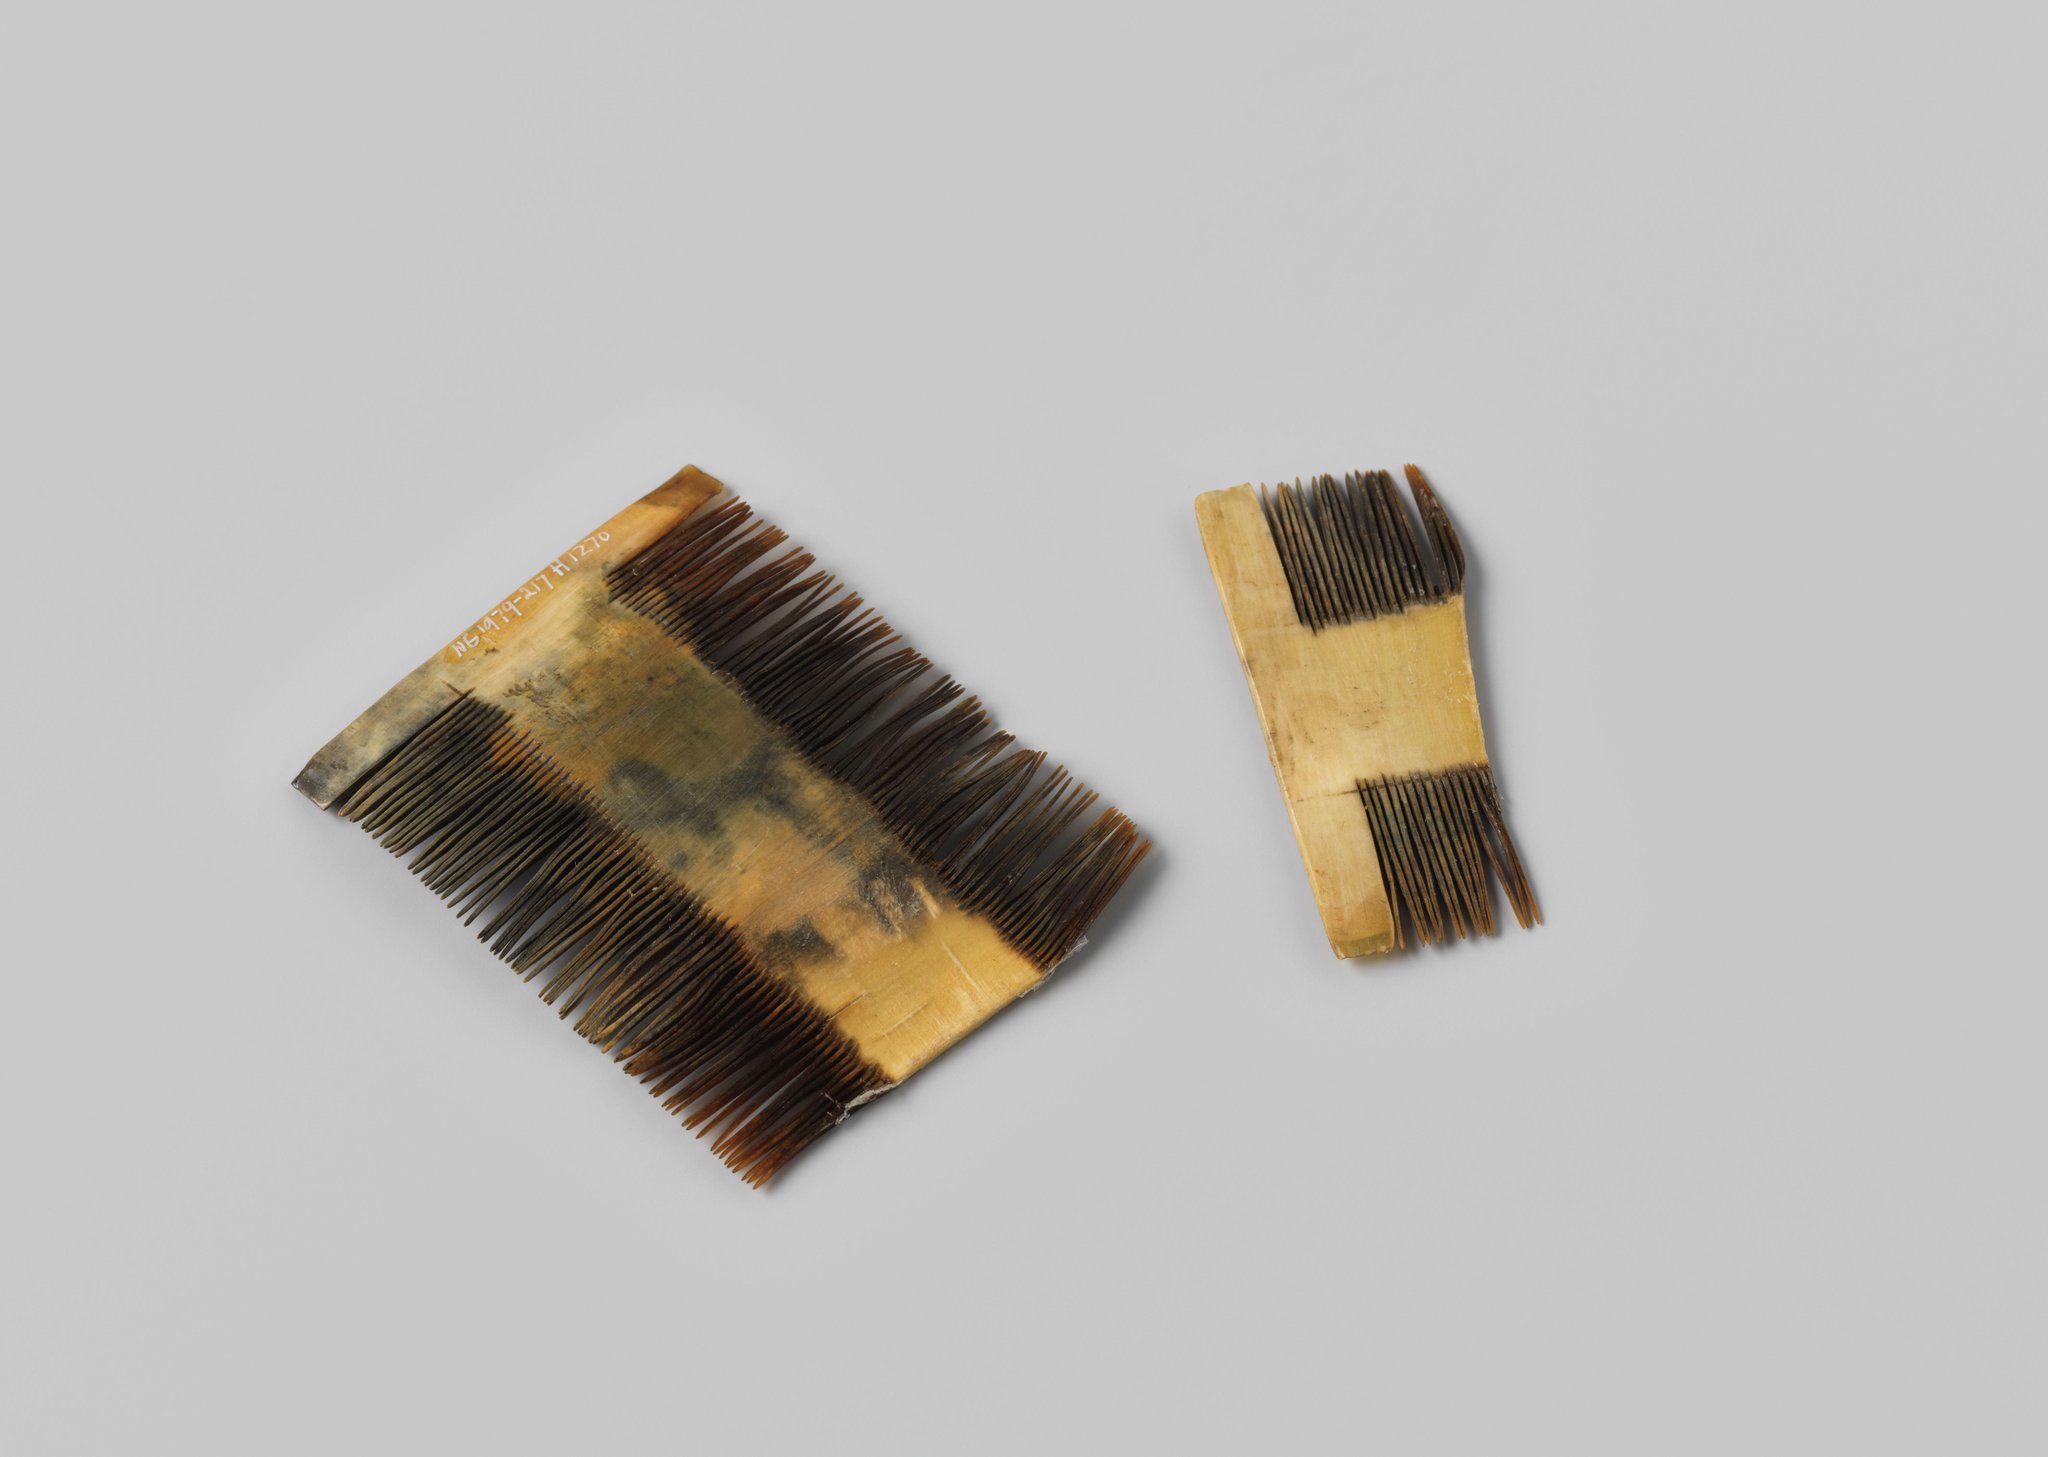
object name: comb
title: Bone comb from the wreck of the Dutch East Indiaman Hollandia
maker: Anonymous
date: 1700-1743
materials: bone, shell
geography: netherlands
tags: verenigde oostindische compagnie, hollandia (schip), annet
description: Comb, fragm, rectangular, double-sided, fine-toothed.